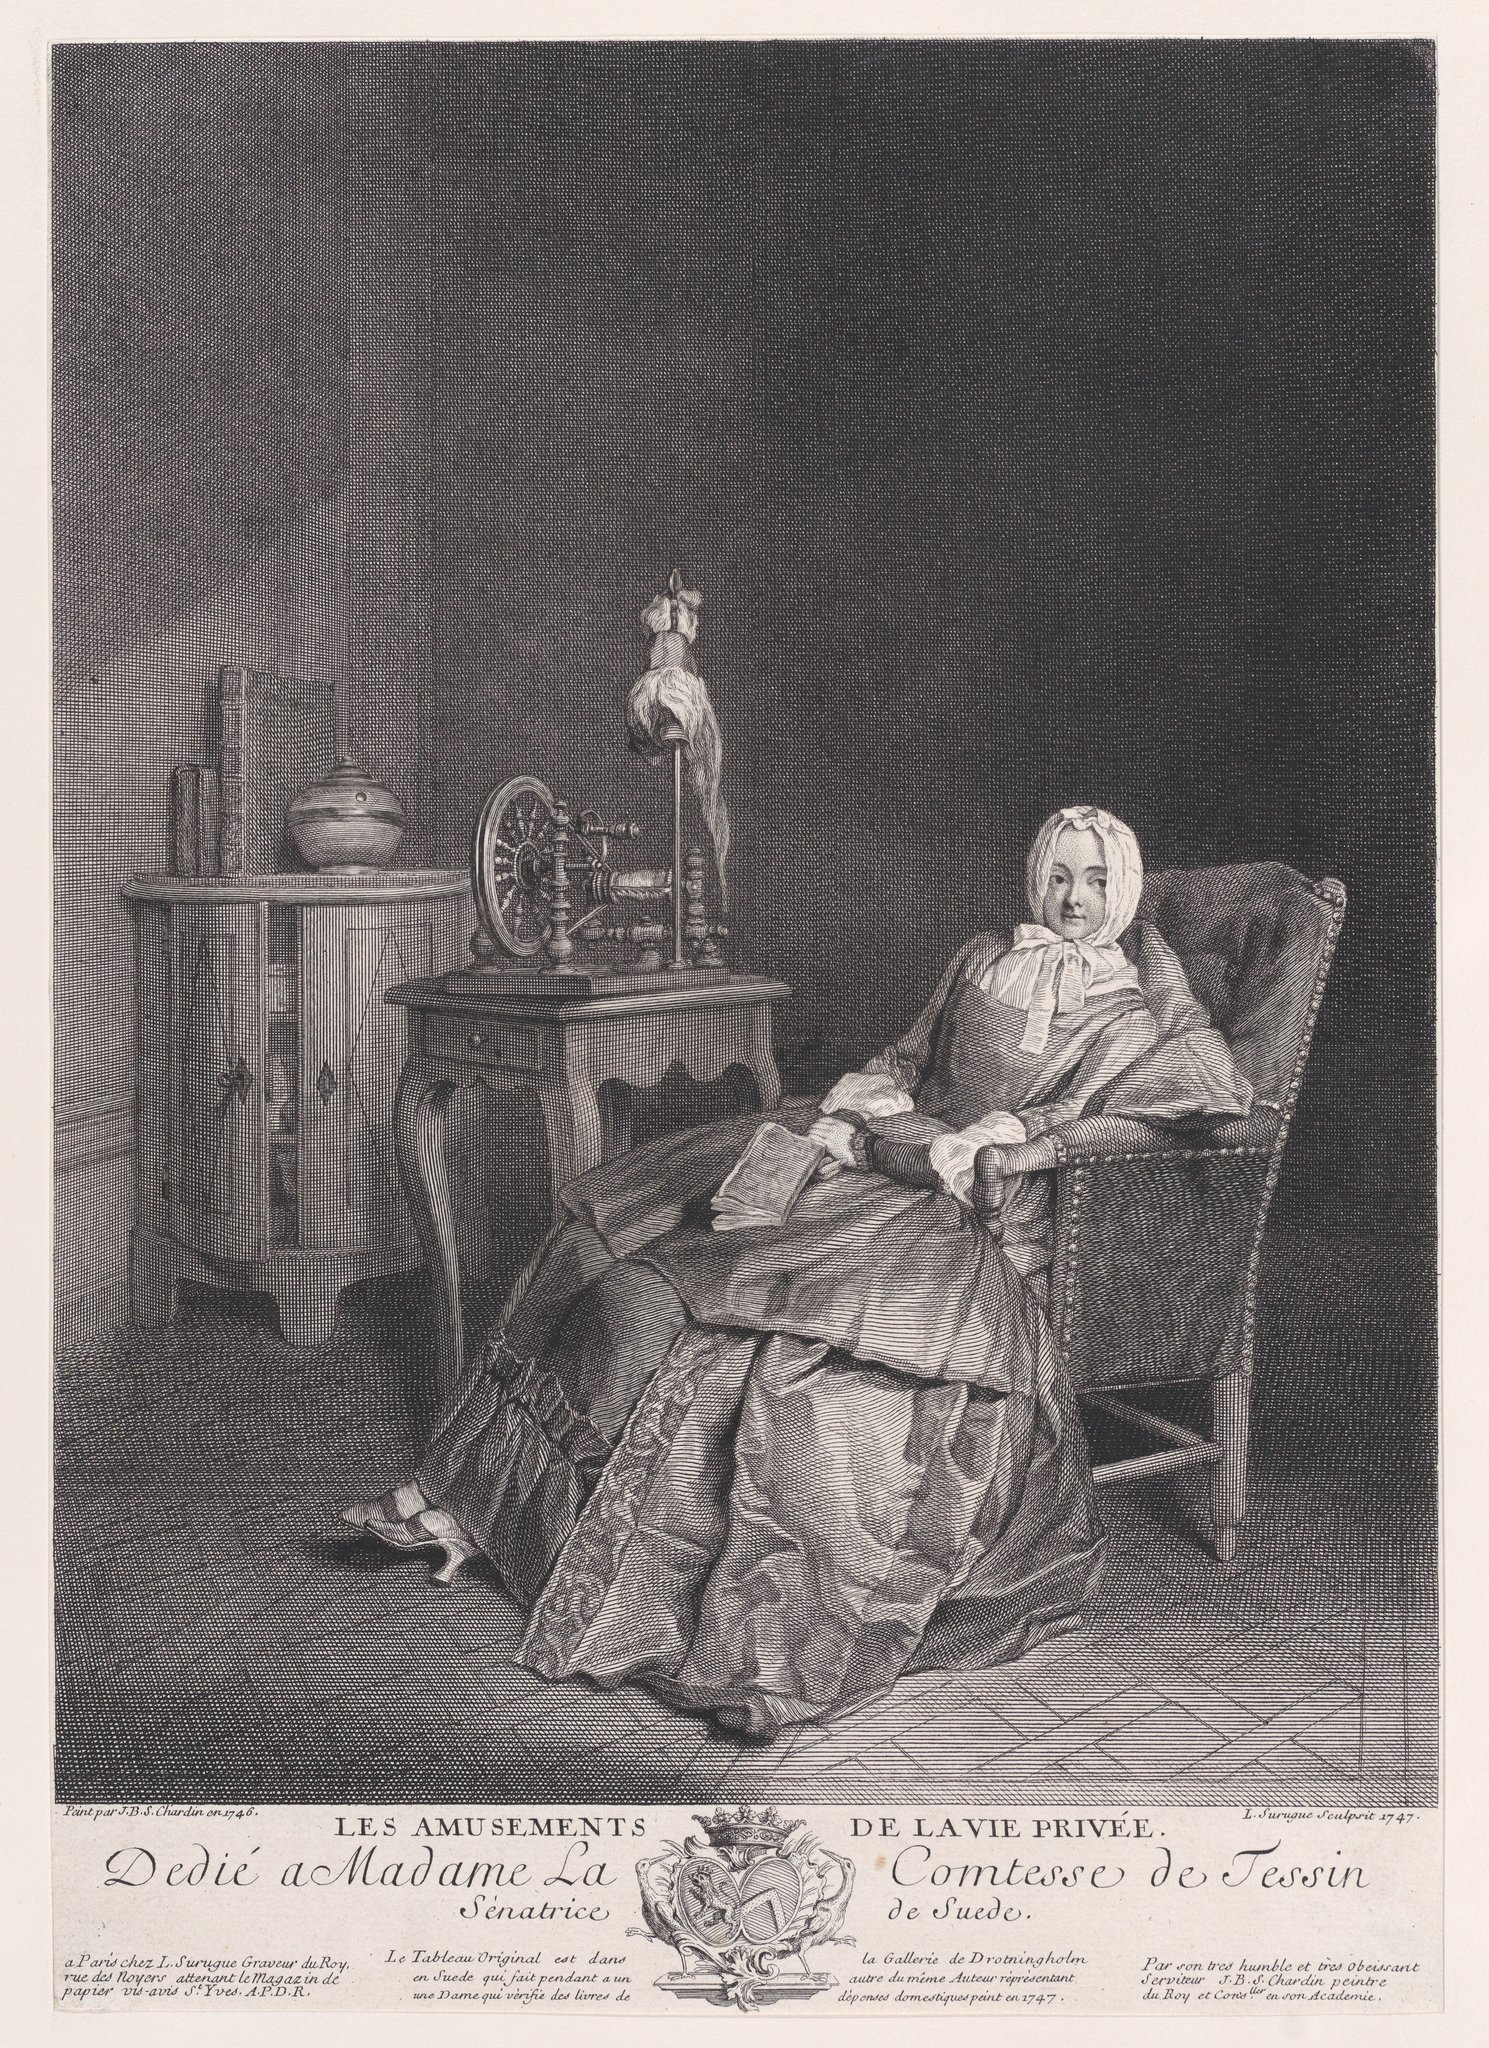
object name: print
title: Domestic Pleasures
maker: louis surugue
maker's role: engraver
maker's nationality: french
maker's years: 1686-1762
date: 1747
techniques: engraving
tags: books,women,spinning wheel